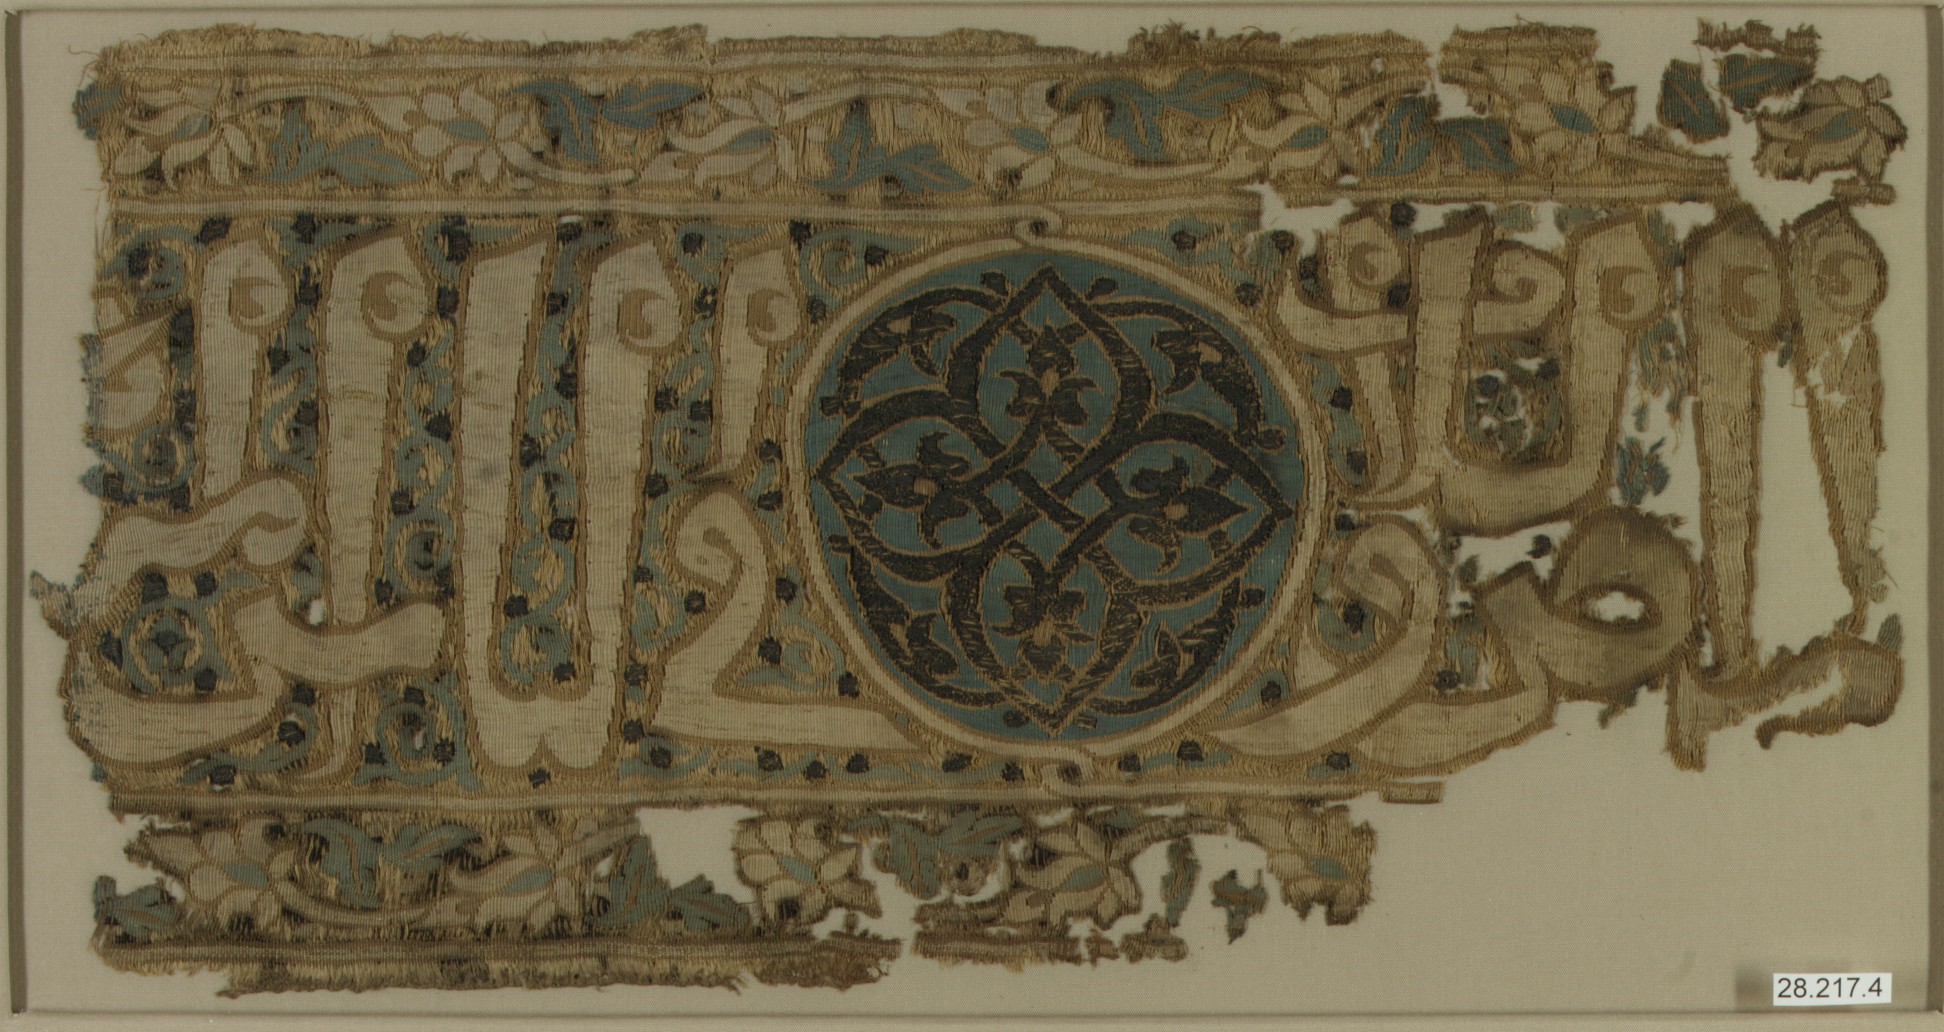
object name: band fragment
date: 1201-1400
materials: metal thread, silk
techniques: weave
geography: egypt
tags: arabic